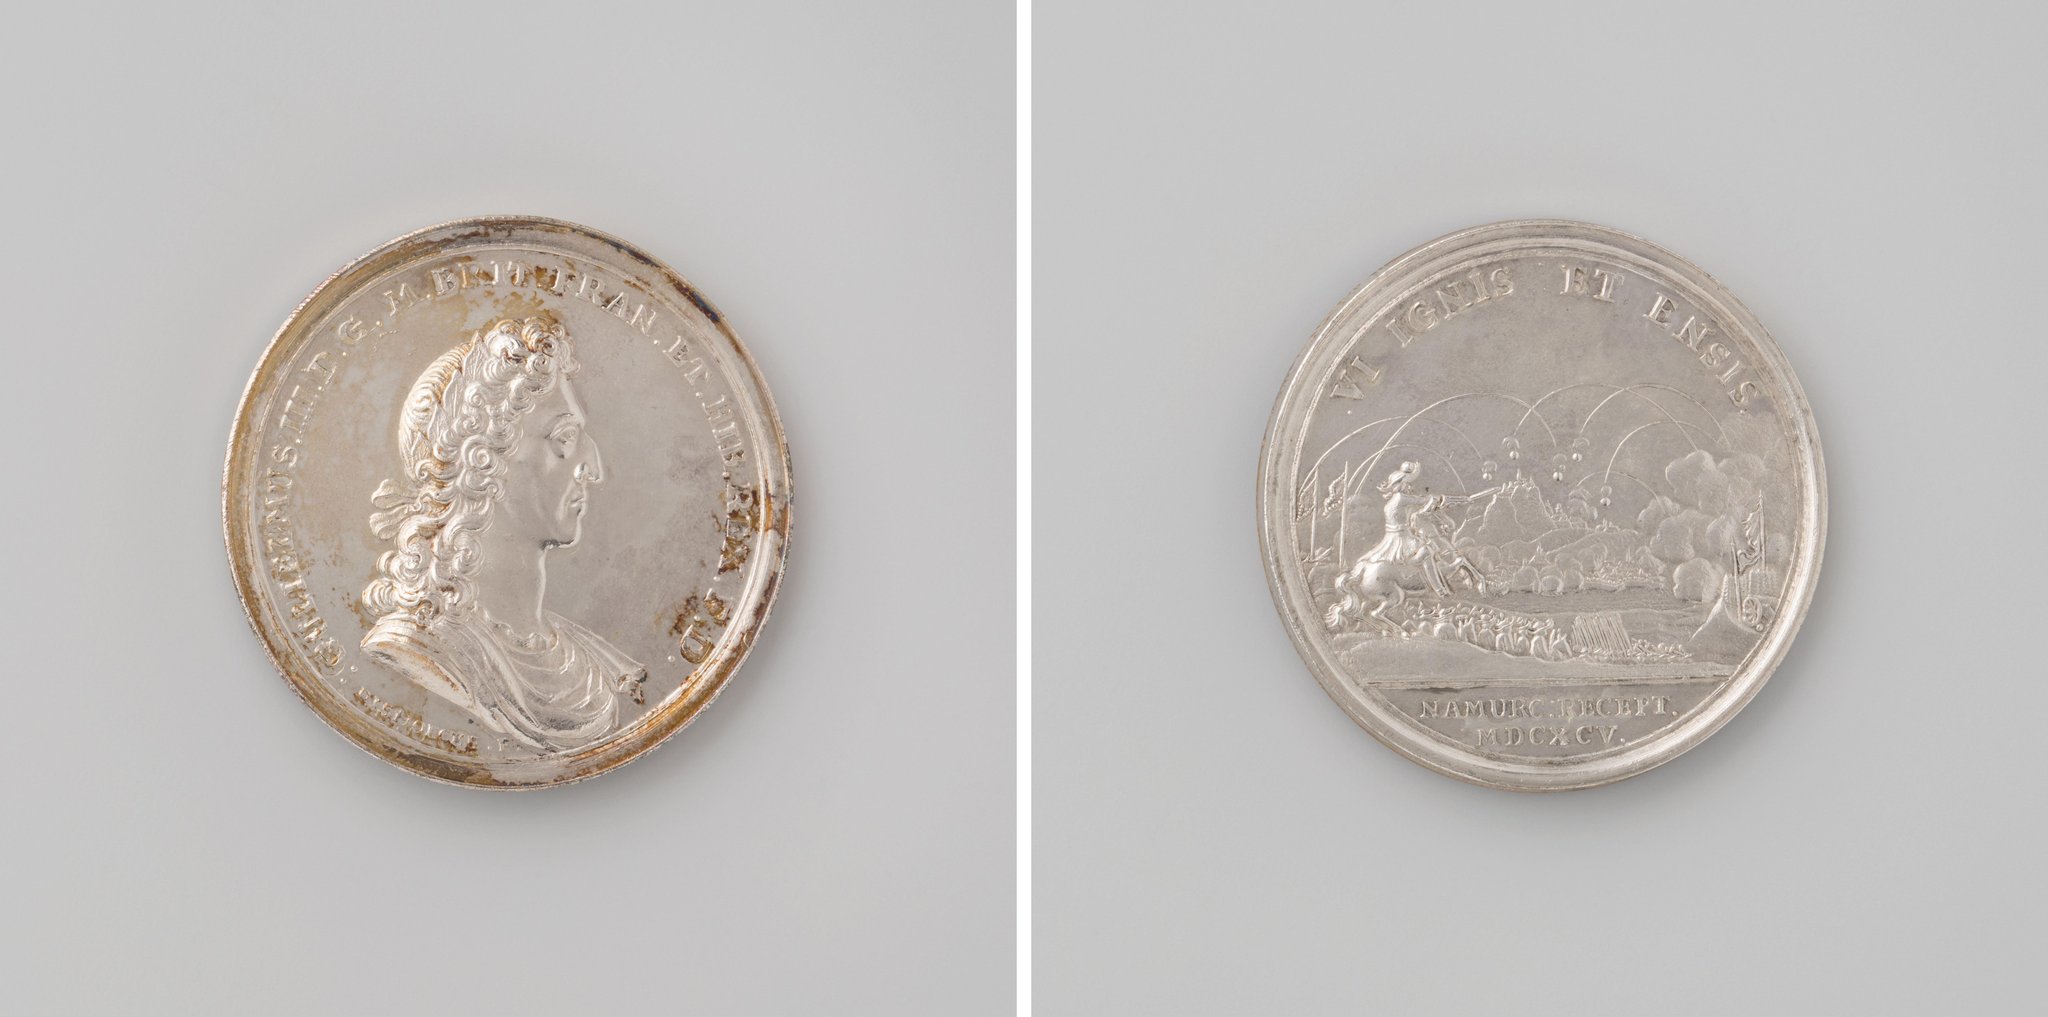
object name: history medal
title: Herovering van Namen door Willem III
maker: jacob van dishoecke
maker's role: silversmith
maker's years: 1650-1723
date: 1695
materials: silver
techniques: striking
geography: amsterdam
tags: the hague, william iii (prince of orange and king of england, scotland, and ireland)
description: Zilveren penning. Voorzijde: borststuk man met lauwerkrans binnen omschrift. Keerzijde: beschieting van stad Namen binnen omschrift; afsnede: opschrift.